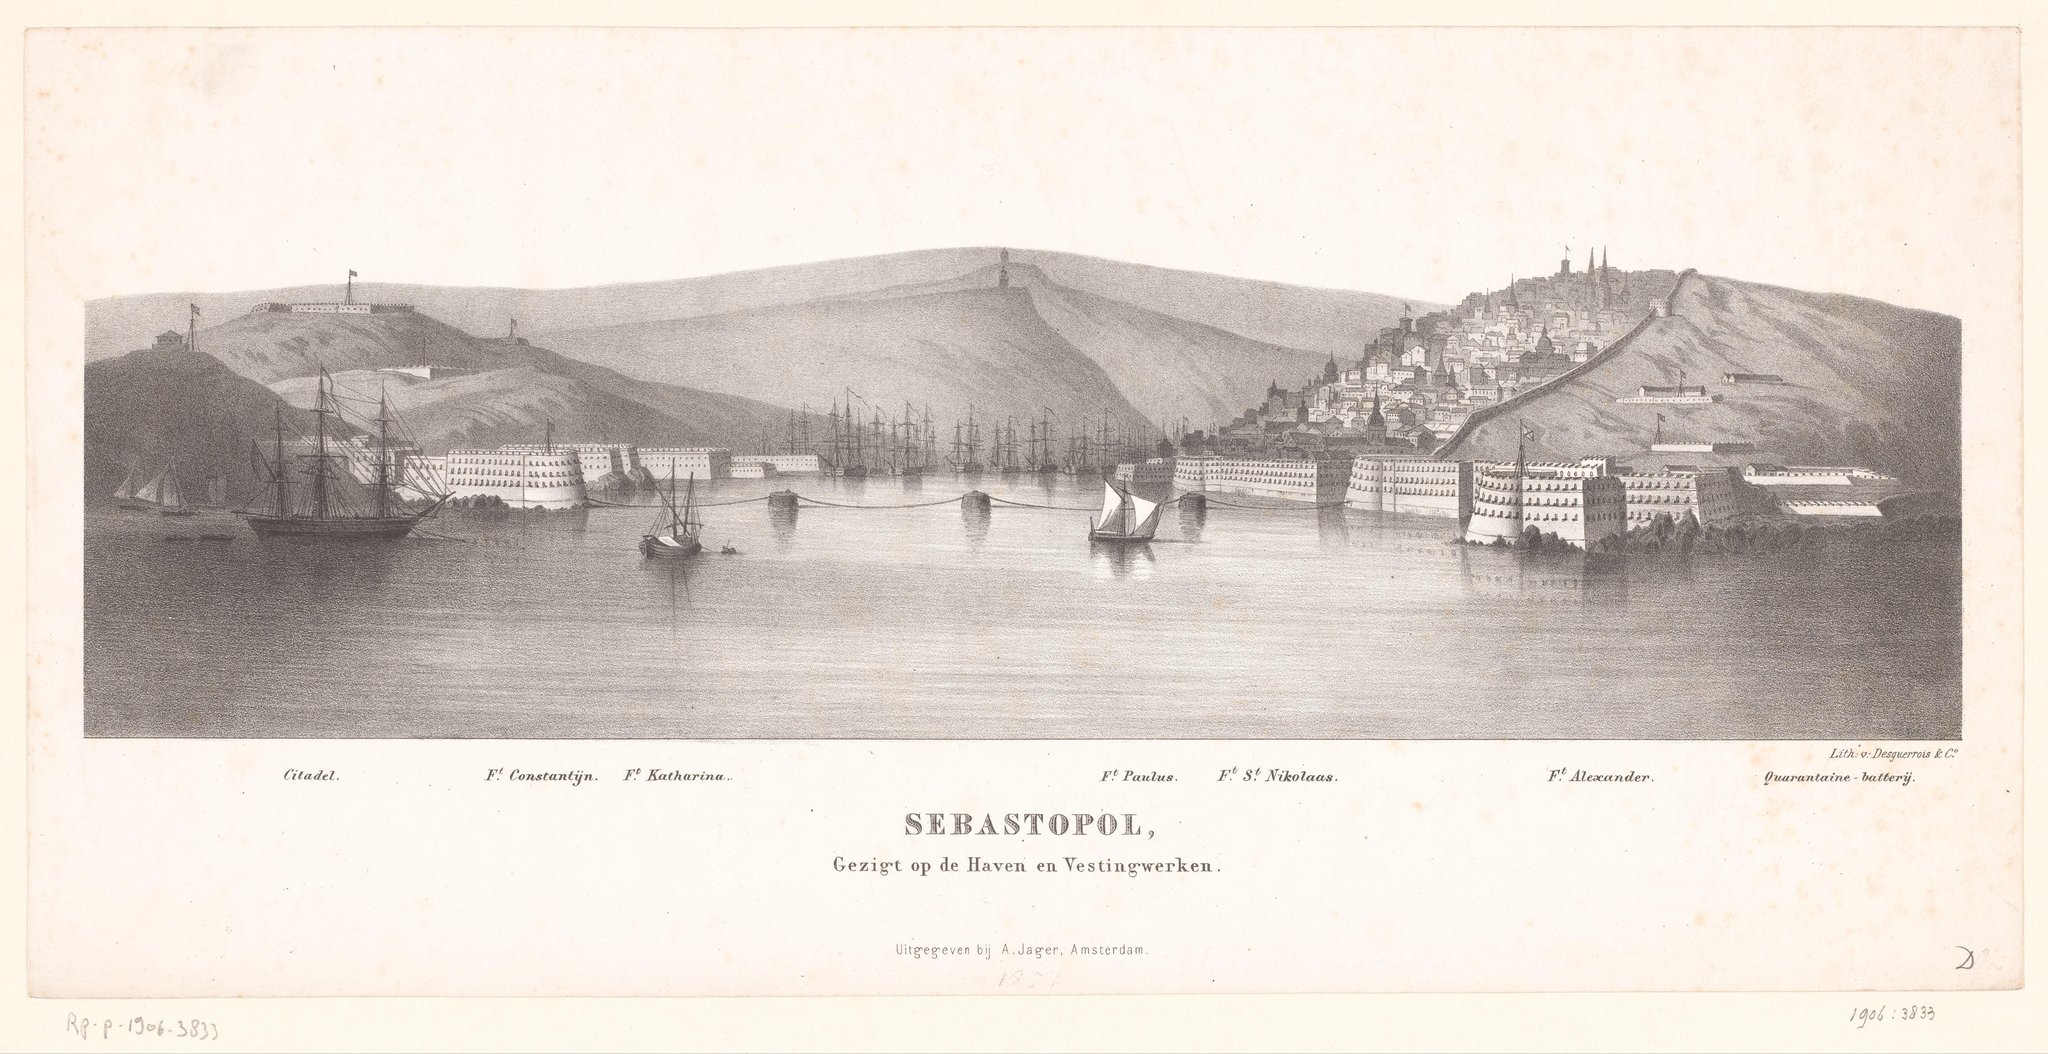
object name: print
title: Sebastopol. Gezigt op de haven en vestingwerken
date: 1858-1905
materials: paper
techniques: lithograph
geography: amsterdam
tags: prospect of city, town panorama, silhouette of city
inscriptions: collector's mark: Lugt 2228